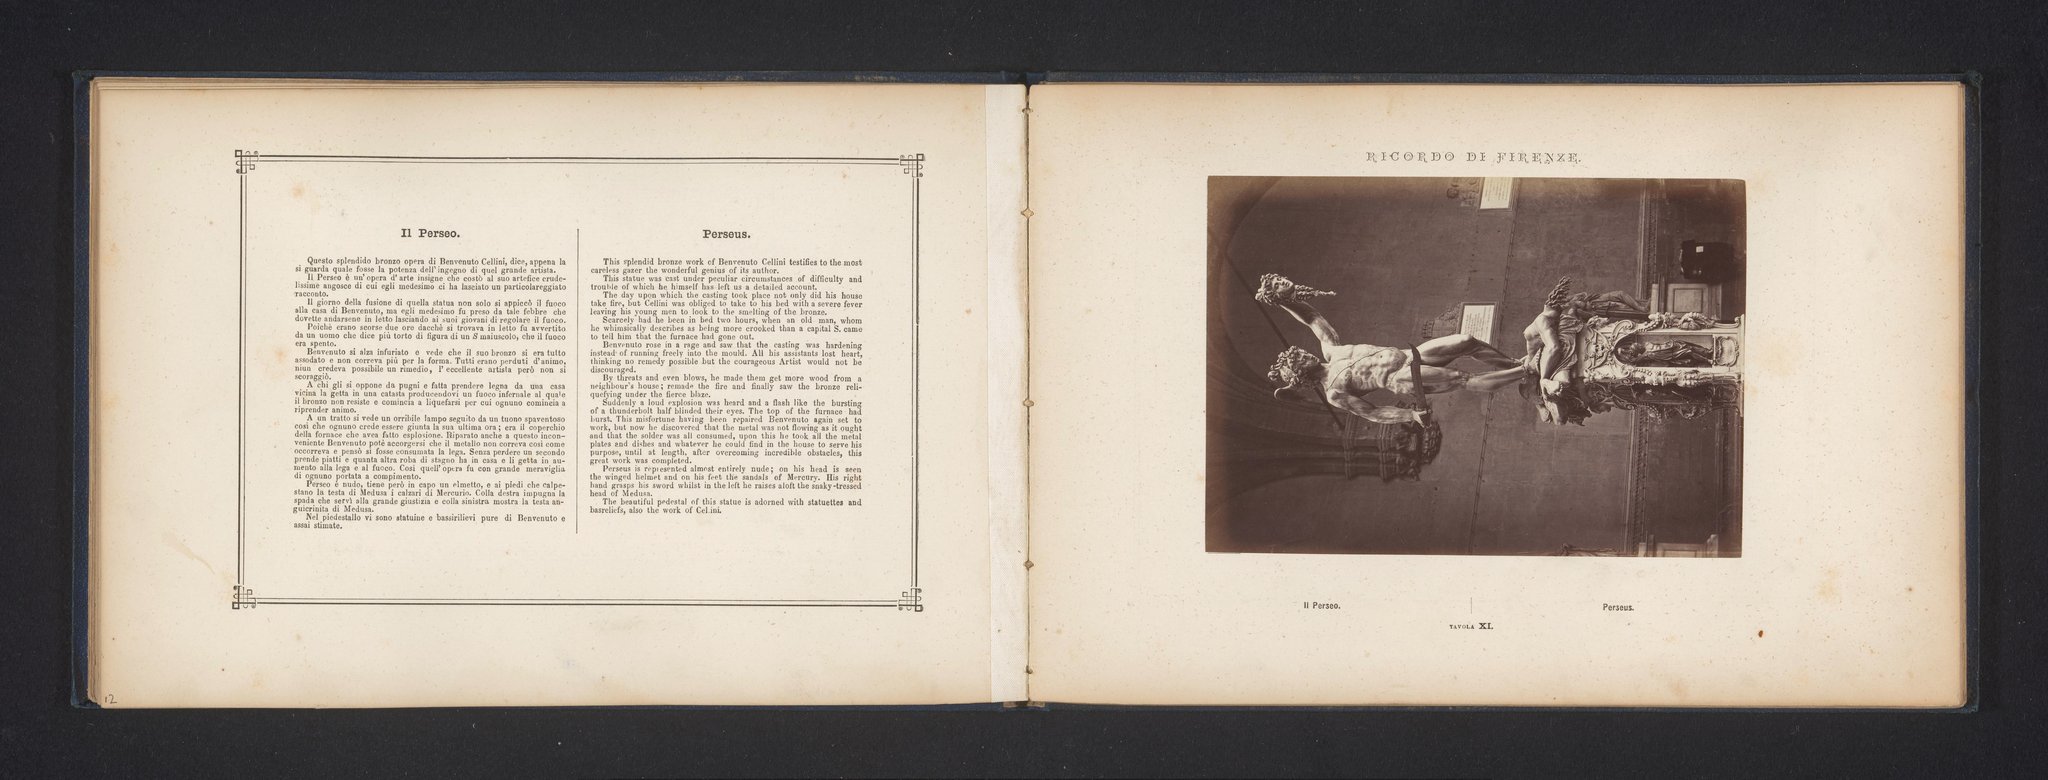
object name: photograph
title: Il Perseo. Perseus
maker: giacomo brogi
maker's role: fotograaf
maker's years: 1822-1881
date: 1861-1871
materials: photographic support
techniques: albumen print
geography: florence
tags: perseus beheading medusa, sculpture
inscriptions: number: ‘Tavola XI.’